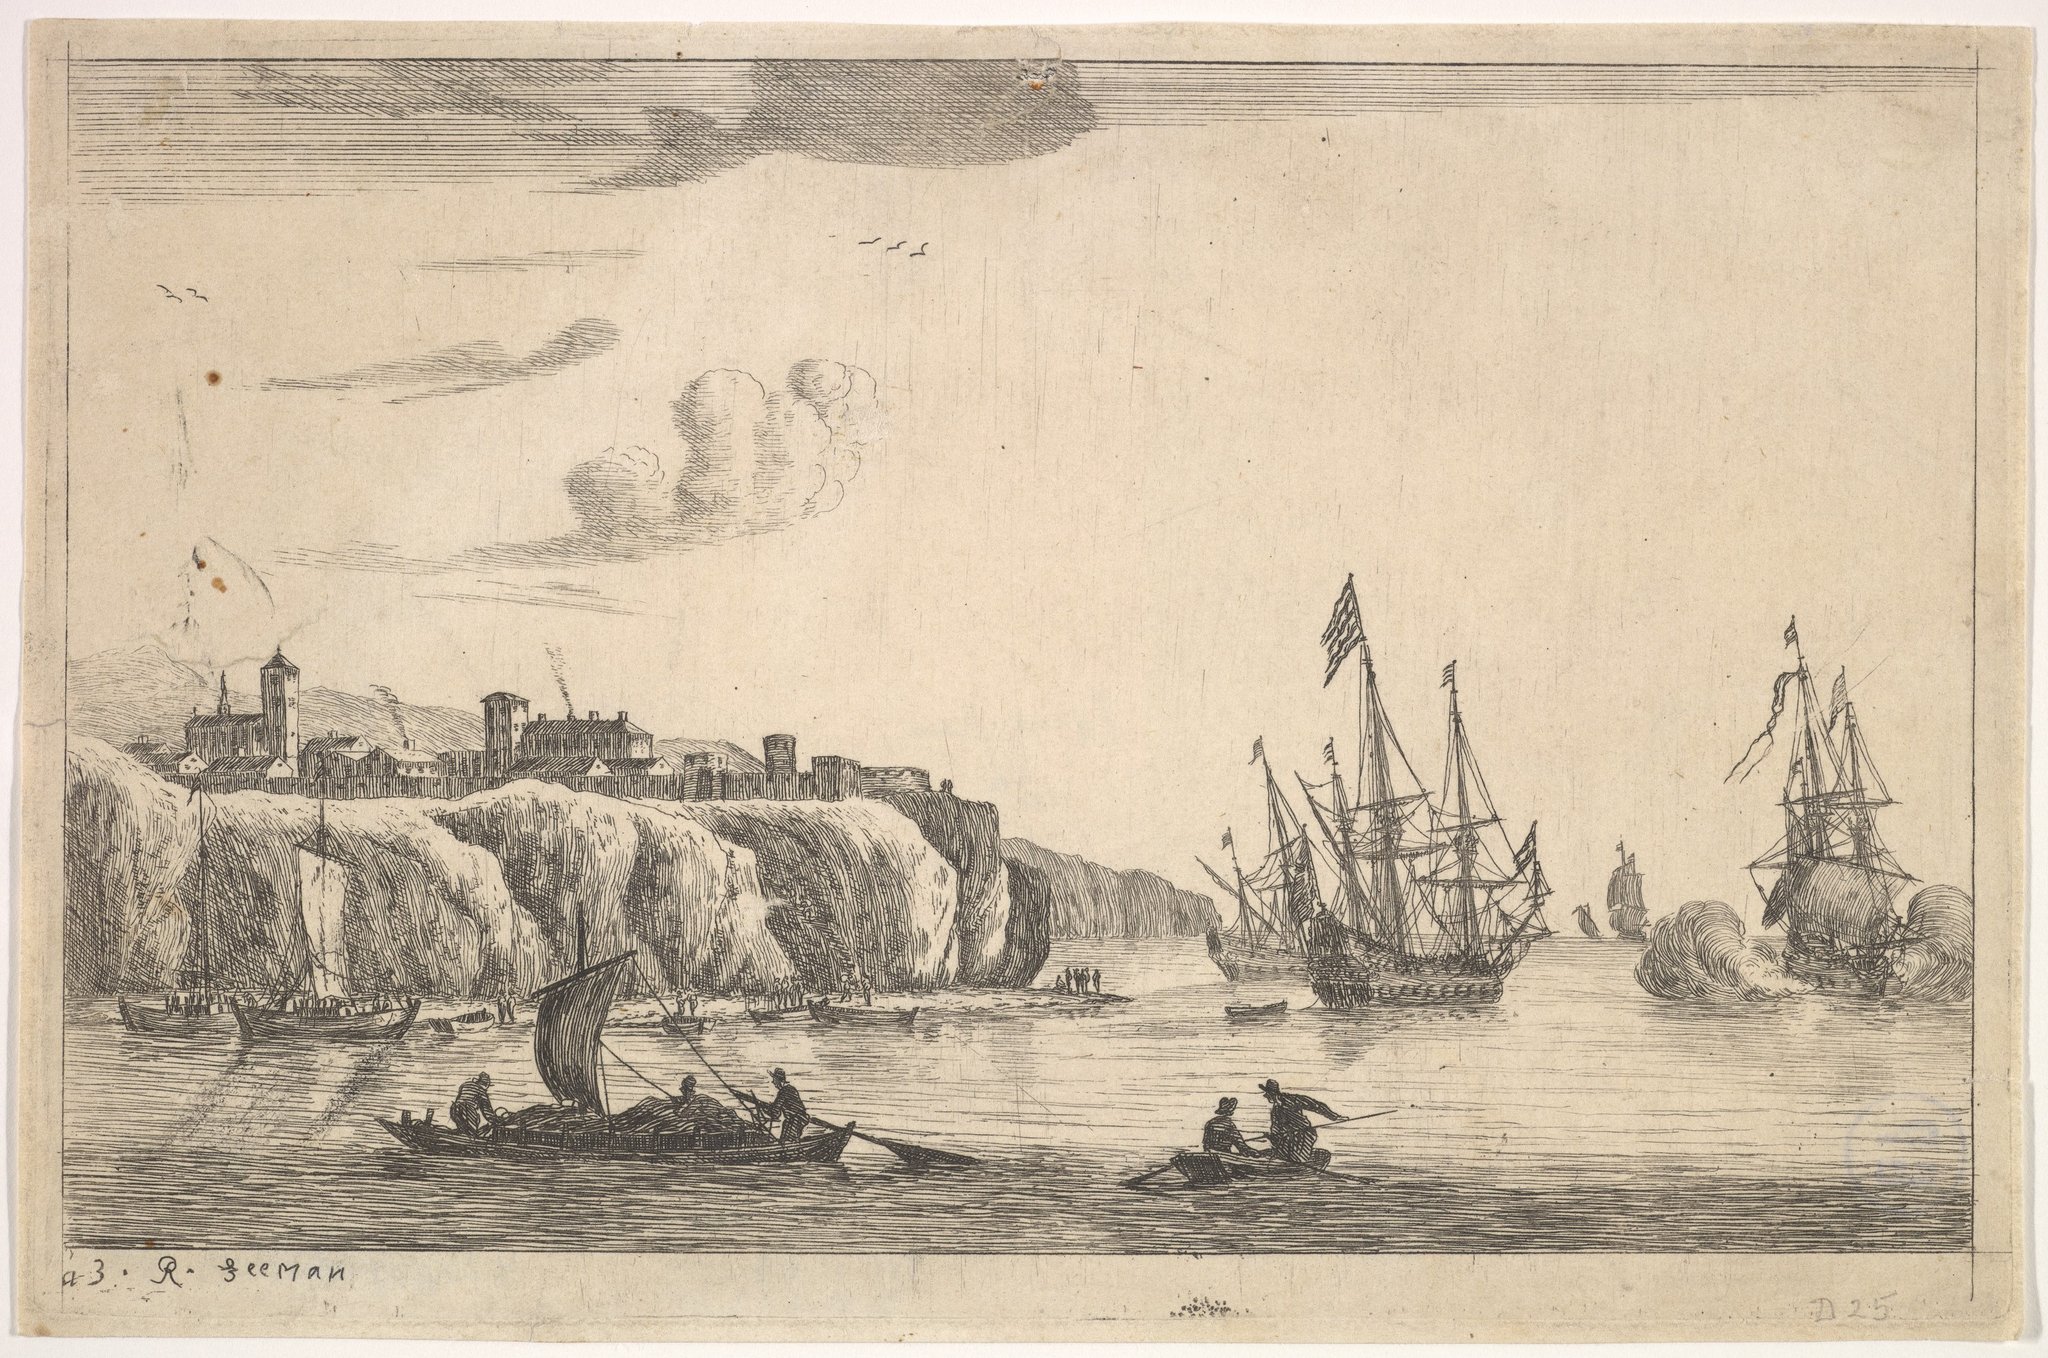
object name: print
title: Seaport with Village on a Cliff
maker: reinier nooms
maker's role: artist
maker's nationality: dutch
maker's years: 1623-1664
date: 1601-1700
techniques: etching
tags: human figures,villages,seas,seascapes,boats,ships